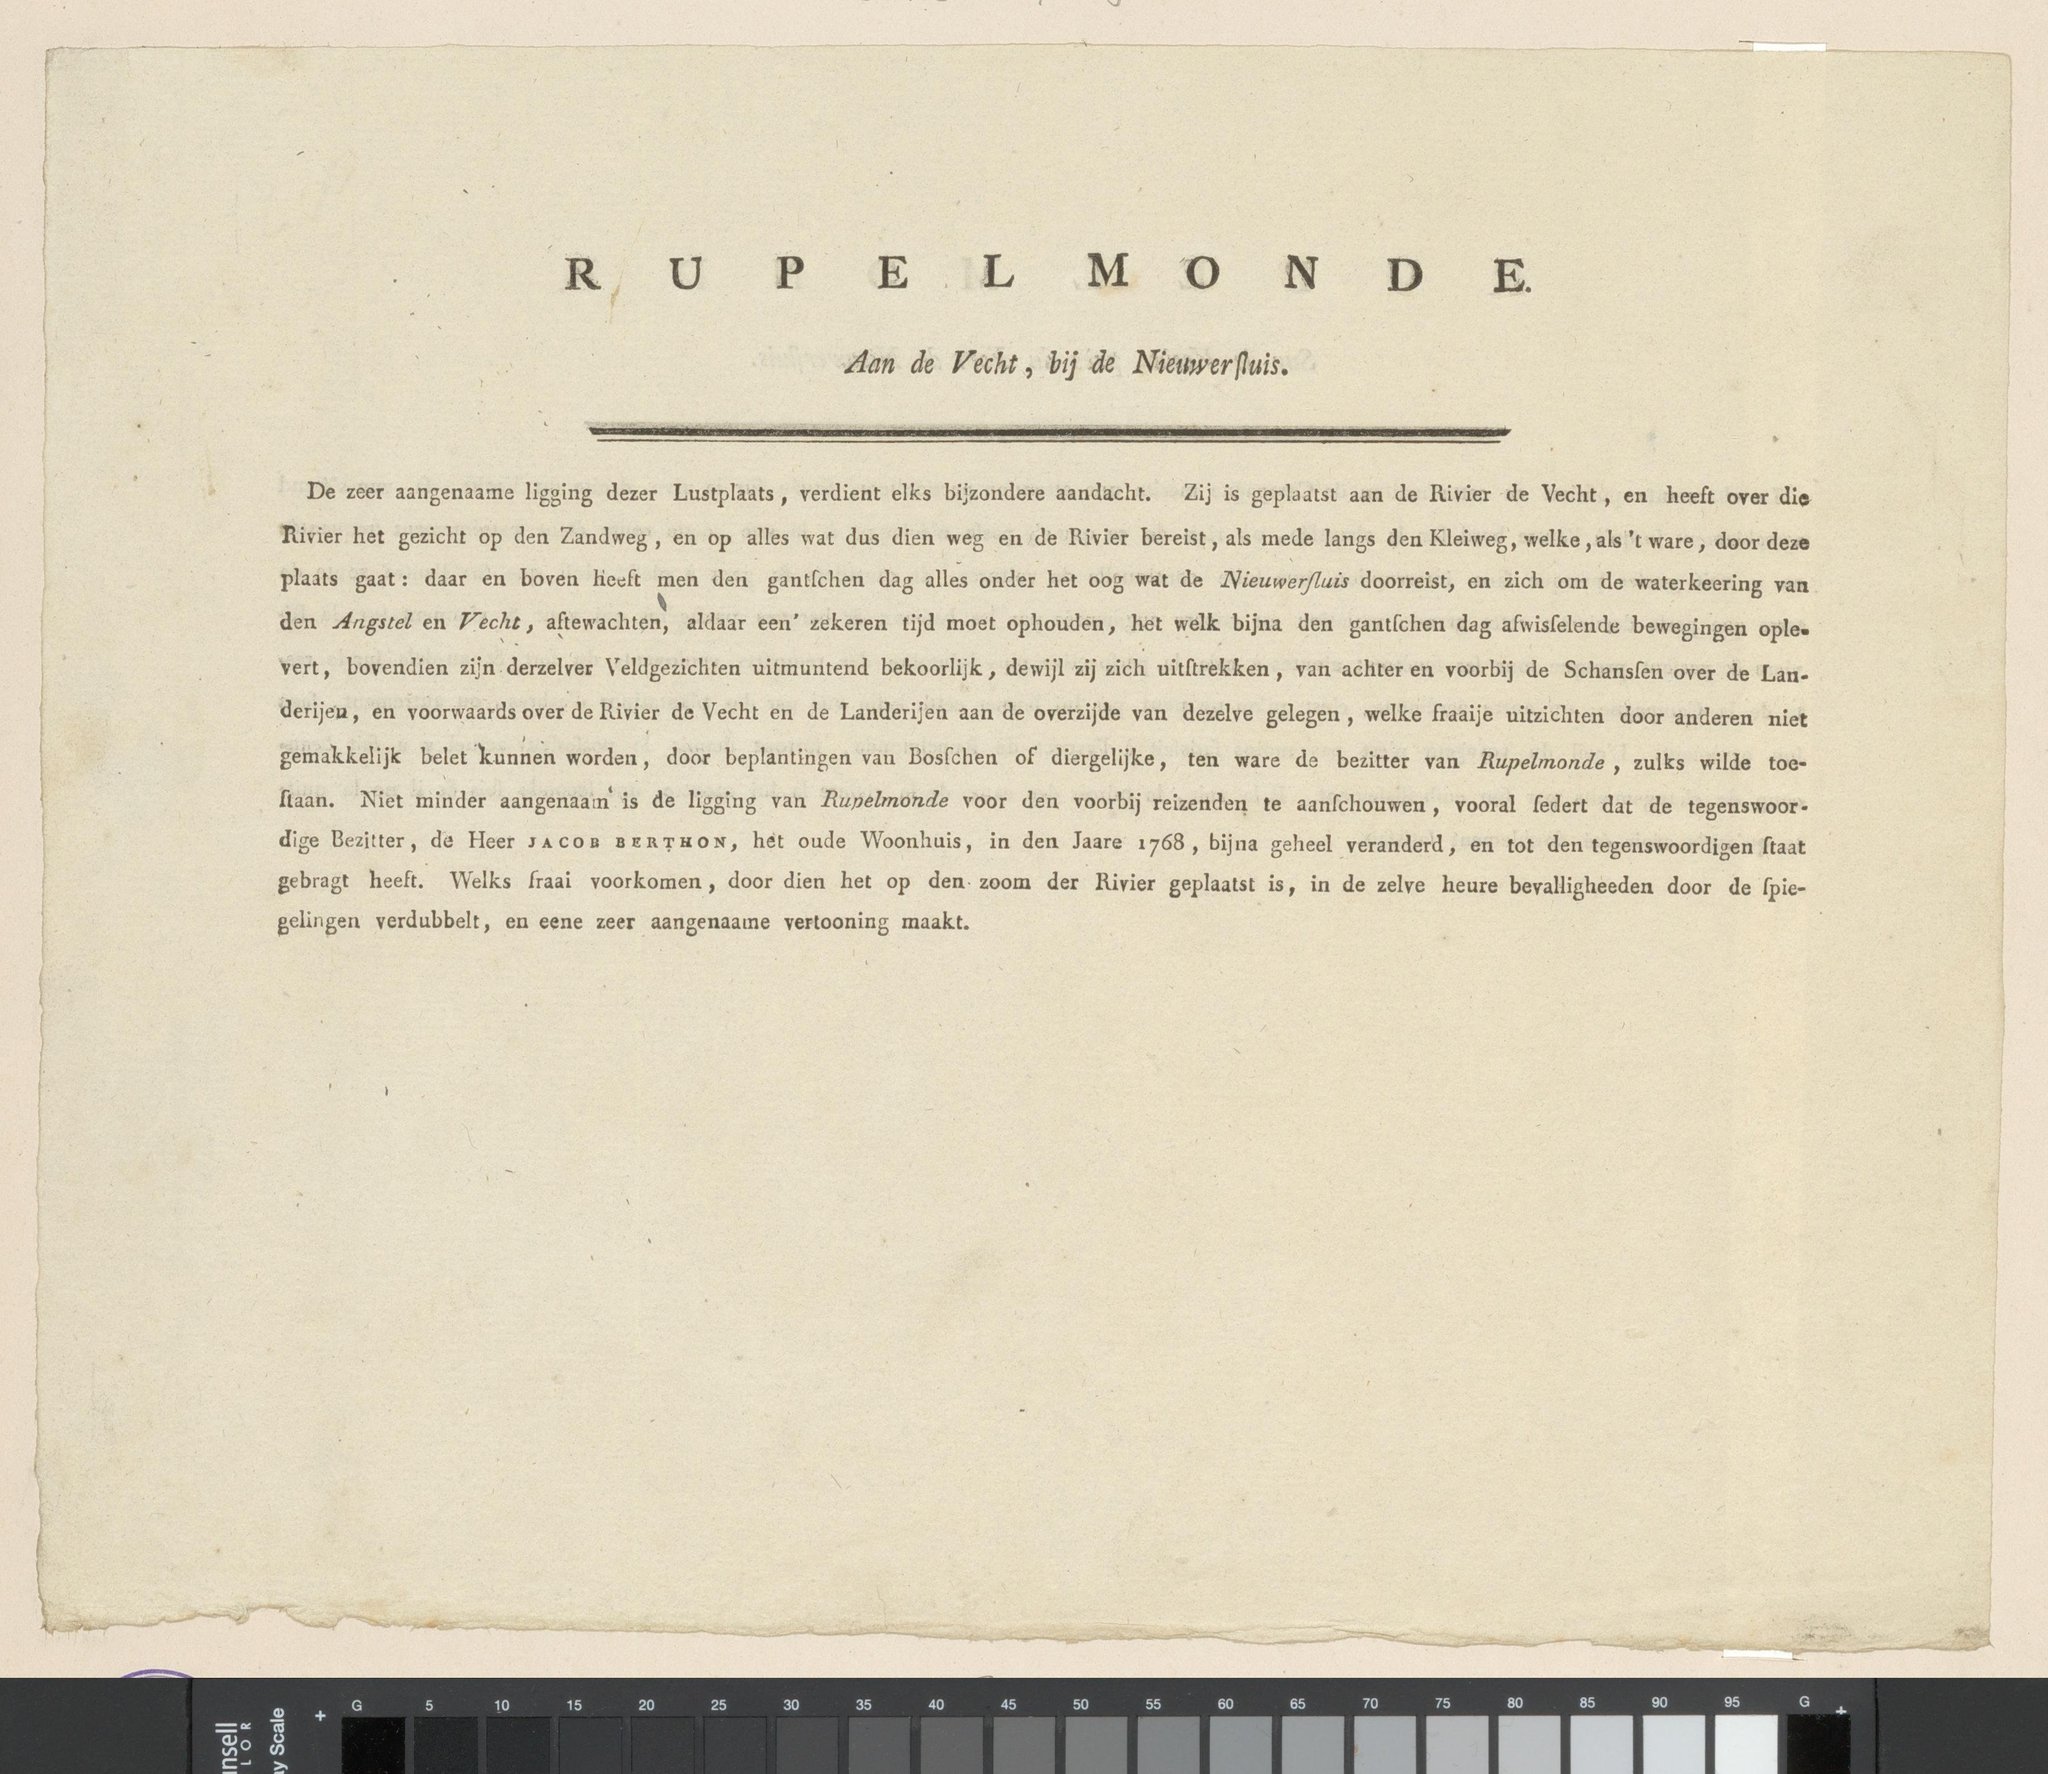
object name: text sheet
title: Rupelmonde, Aan de Vecht, bij de Nieuwersluis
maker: hermanus numan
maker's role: draughtsman, painter, print maker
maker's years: 1744-1820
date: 1797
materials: paper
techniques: letterpress printing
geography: amsterdam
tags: country-house, vecht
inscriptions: stamp, collector's mark: Lugt 1641, stamp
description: Tekstblad uit: Numan, Hermanus. Vierentwintig printtekeningen met couleuren, verbeeldende Hollandsche buitenplaatzen, met derzelver beschrijvingen (...). Amsterdam: Hermanus Numan, 1797.